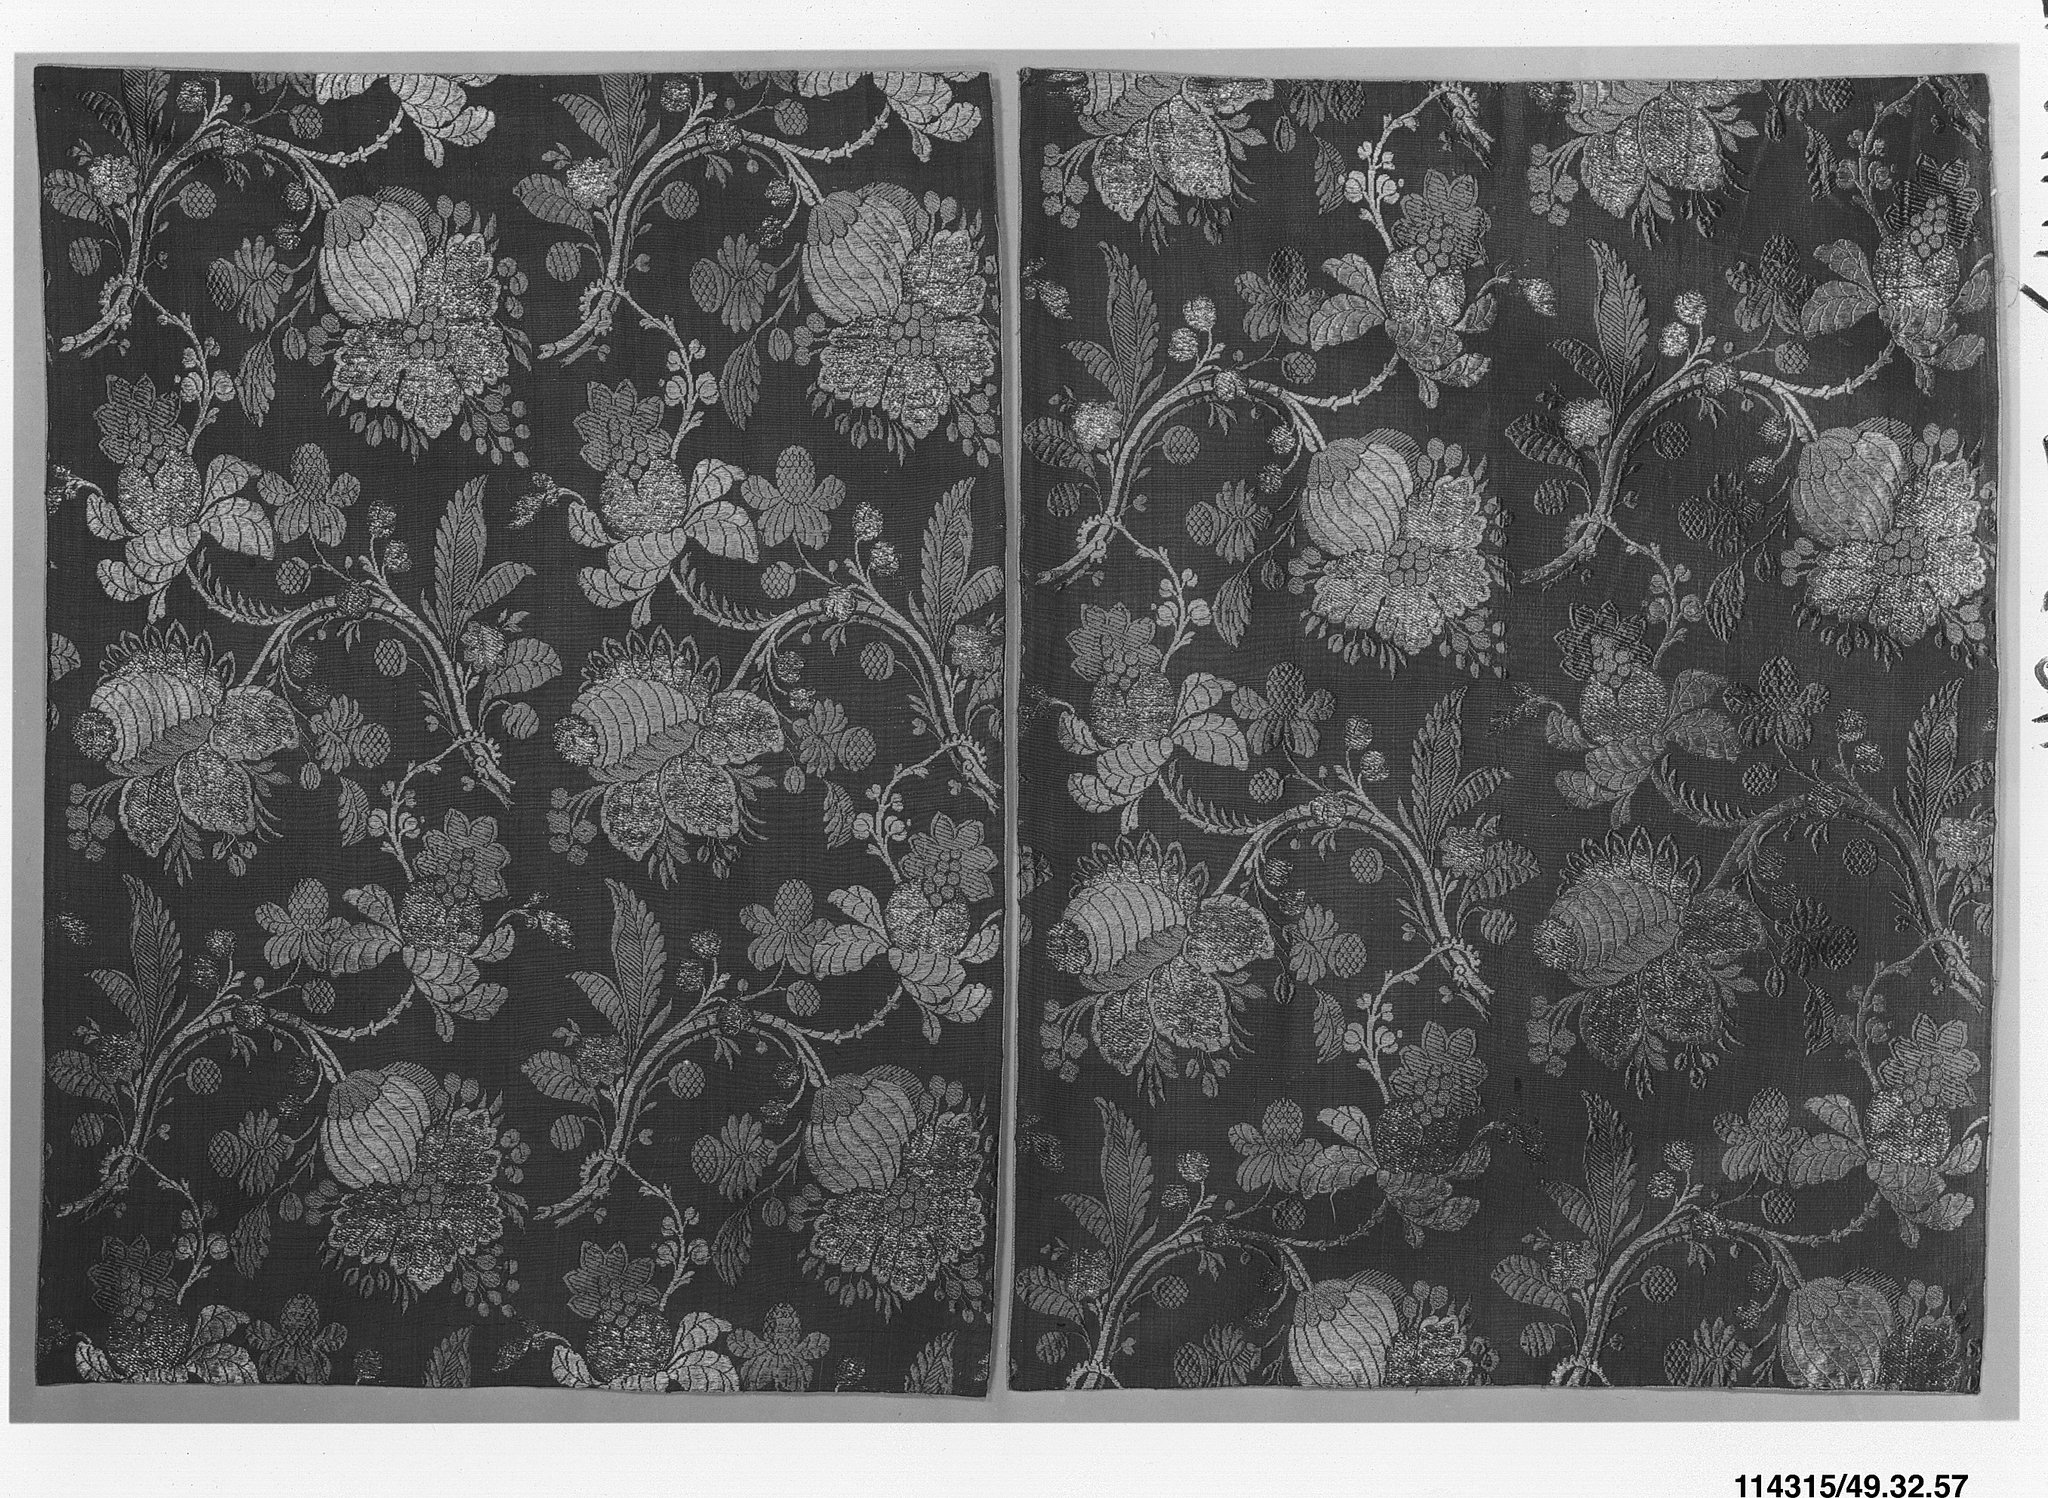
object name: panel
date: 1750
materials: metal thread, silk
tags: flowers